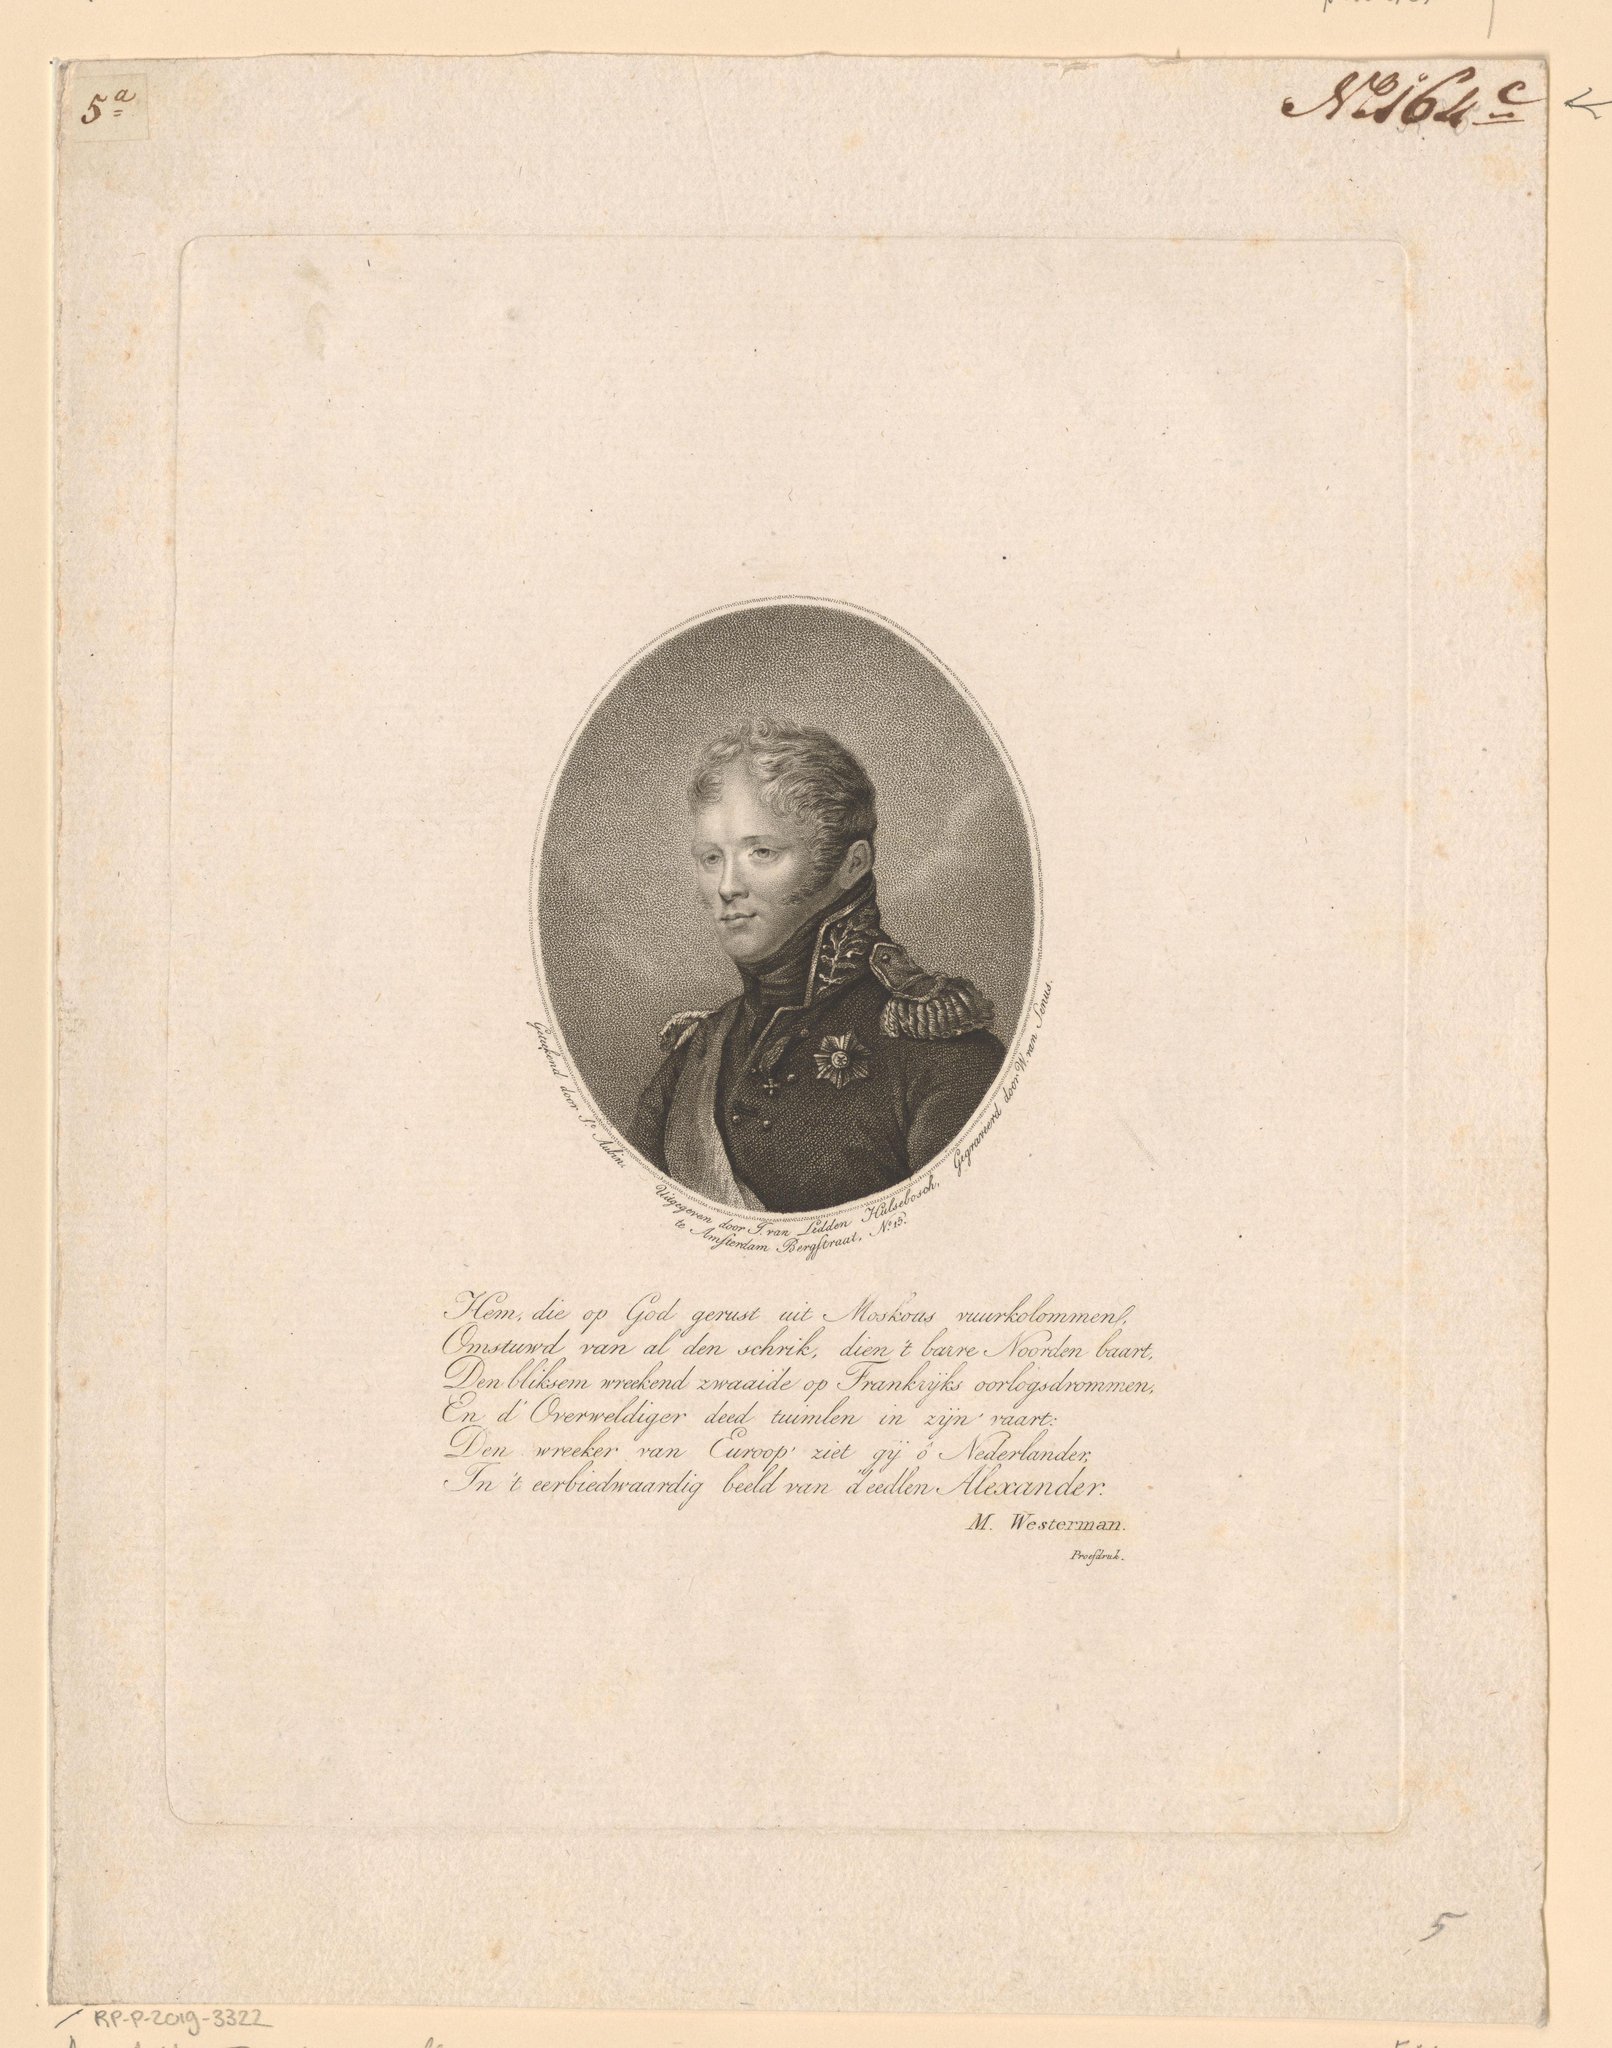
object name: print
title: Portret van Alexander I, tsaar van Rusland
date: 1814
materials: paper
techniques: etching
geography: amsterdam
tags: alexander i (tsaar van rusland), historical persons, emperor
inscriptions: inscription: ‘5a’, inscription: ‘No 164 c.’